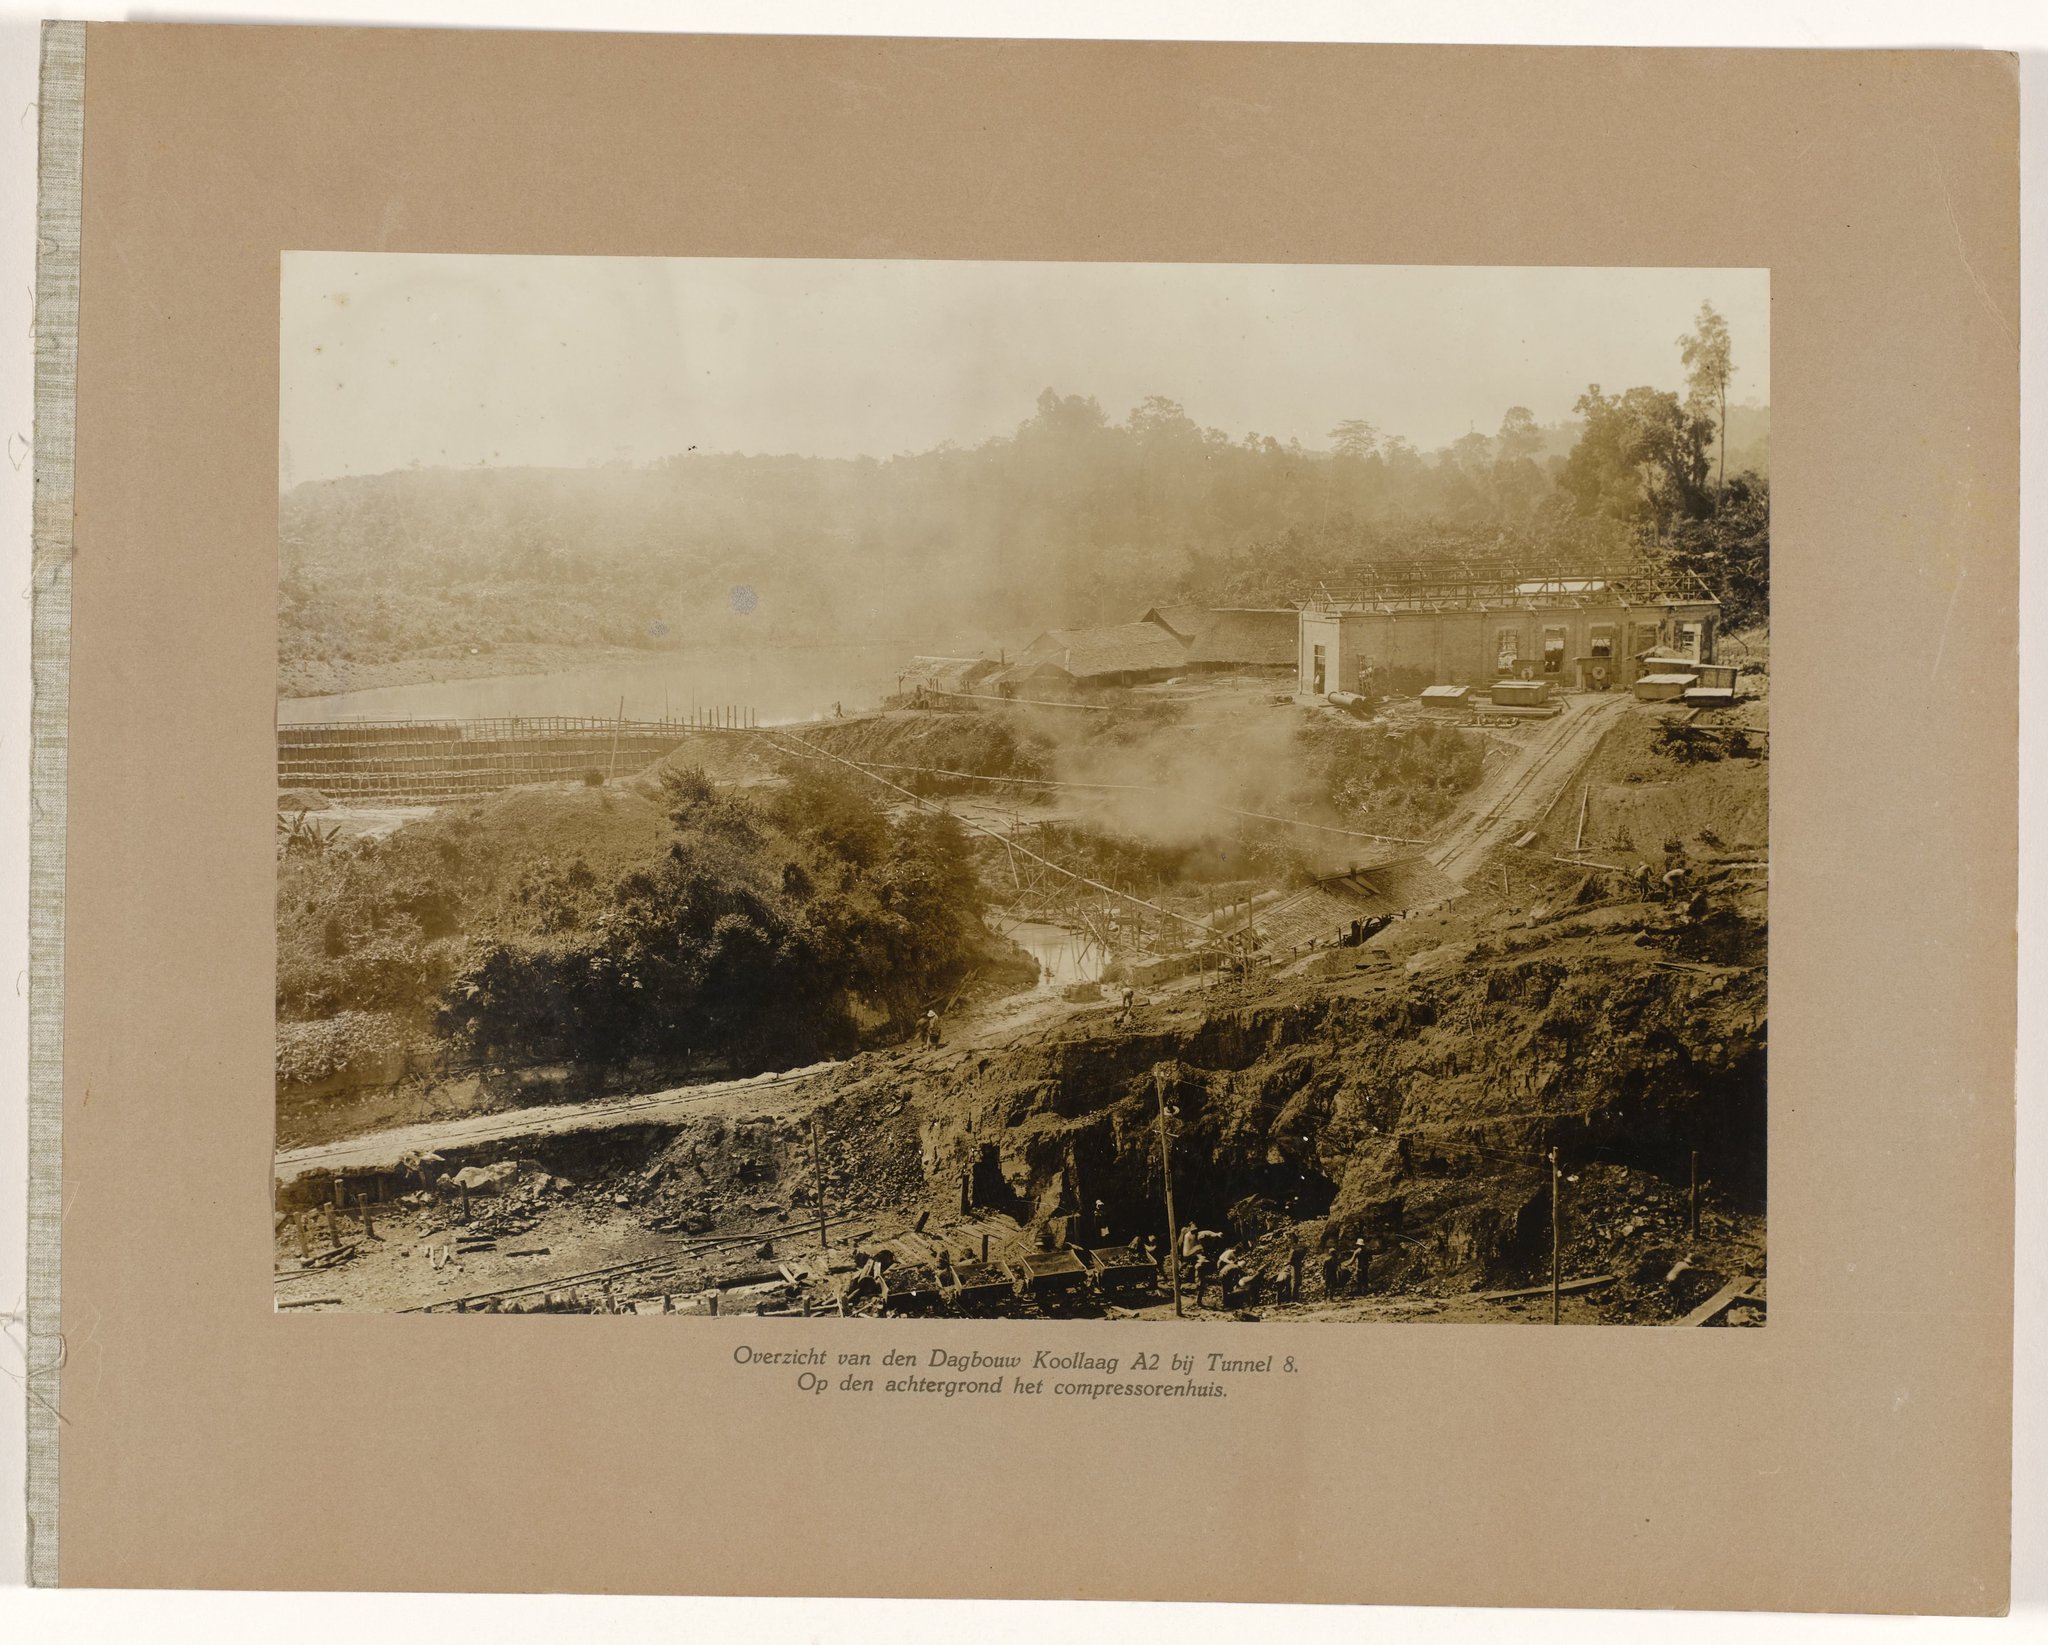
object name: photograph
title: Overzicht van den Dagbouw Koollaag A2 bij Tunnel 8. Op den achtergrond het compressorenhuis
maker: Anonymous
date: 1921-1922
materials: photographic support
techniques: gelatin silver print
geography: bukit asam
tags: colonial system, anthracite, hard coal, surface structures and surroundings of a mine, opencast mine; strip mining (+ coal), sumatra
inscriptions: inscription: ‘Overzicht van den Dagbouw Koollaag A2 bij Tunnel 8. Op den achtergrond het compressorenhuis.’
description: Overzicht van de steenkoolwinning in de open mijn (dagbouw). Op de voorgrond de blootliggende koollaag met arbeiders bij kiepkarretjes. Op de achtergrond links een afgedamd meertje en rechts fabrieksgebouwen. Onderdeel van het losbladige fotoalbum aangeboden door het personeel van de Boekit-Asam Steenkolenmijnen op Sumatra aan de scheidende Ingenieur-Directeur H. Tromp op 7 januari 1922.